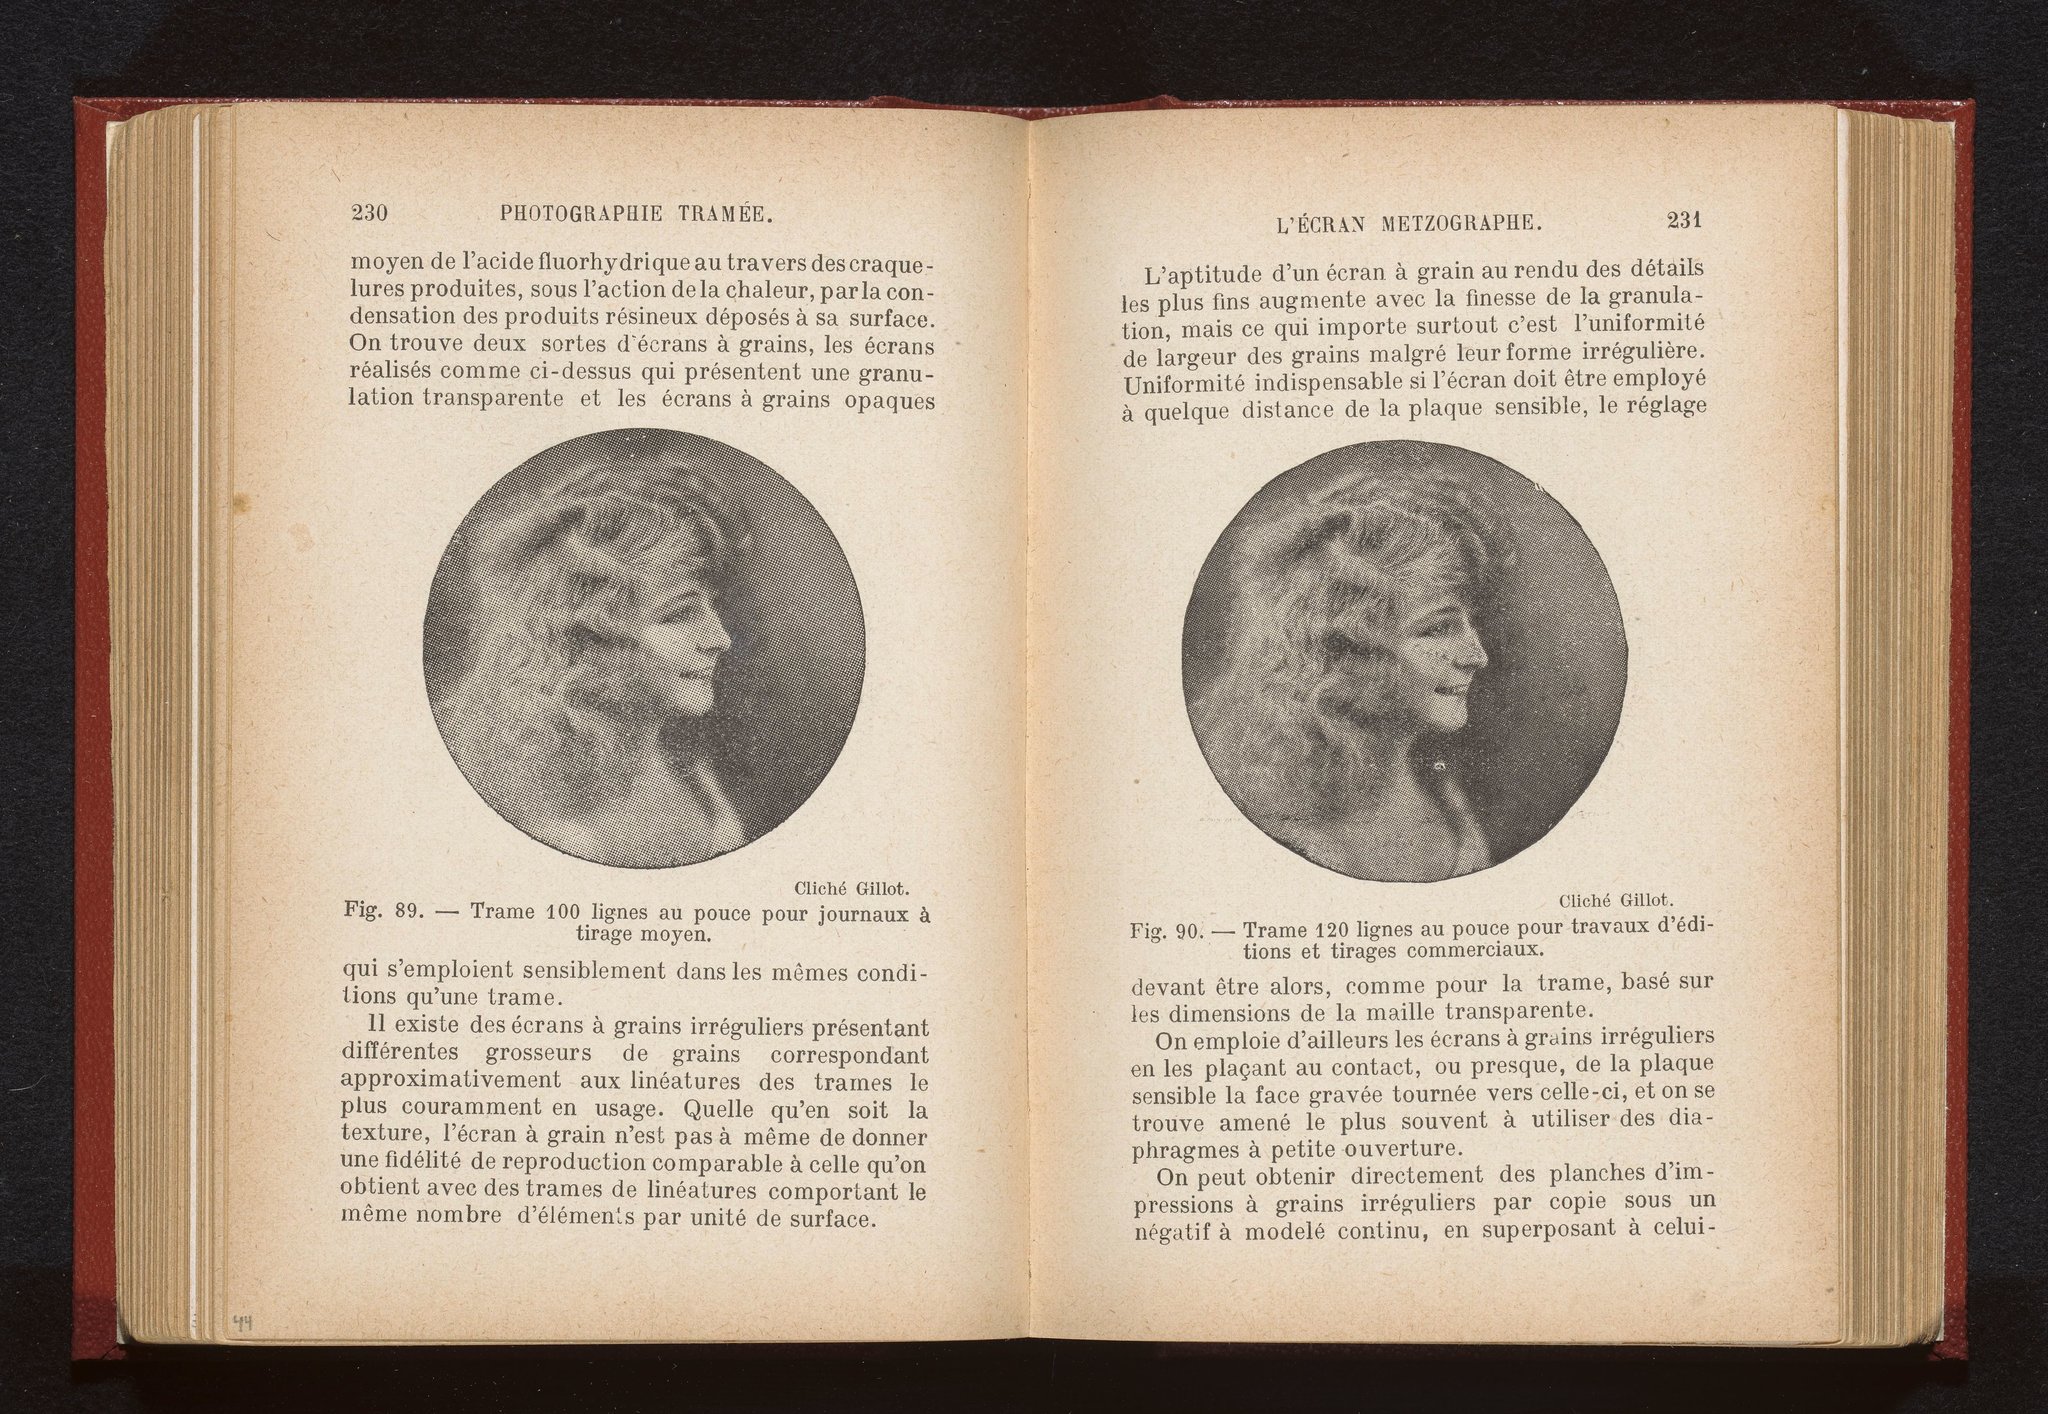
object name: page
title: Trame 120 lignes au pouce pour travaux d'éditions et tirages commerciaux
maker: Anonymous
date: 1922-1932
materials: paper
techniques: autotype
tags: adult woman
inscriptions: number: ‘Fig. 90.’